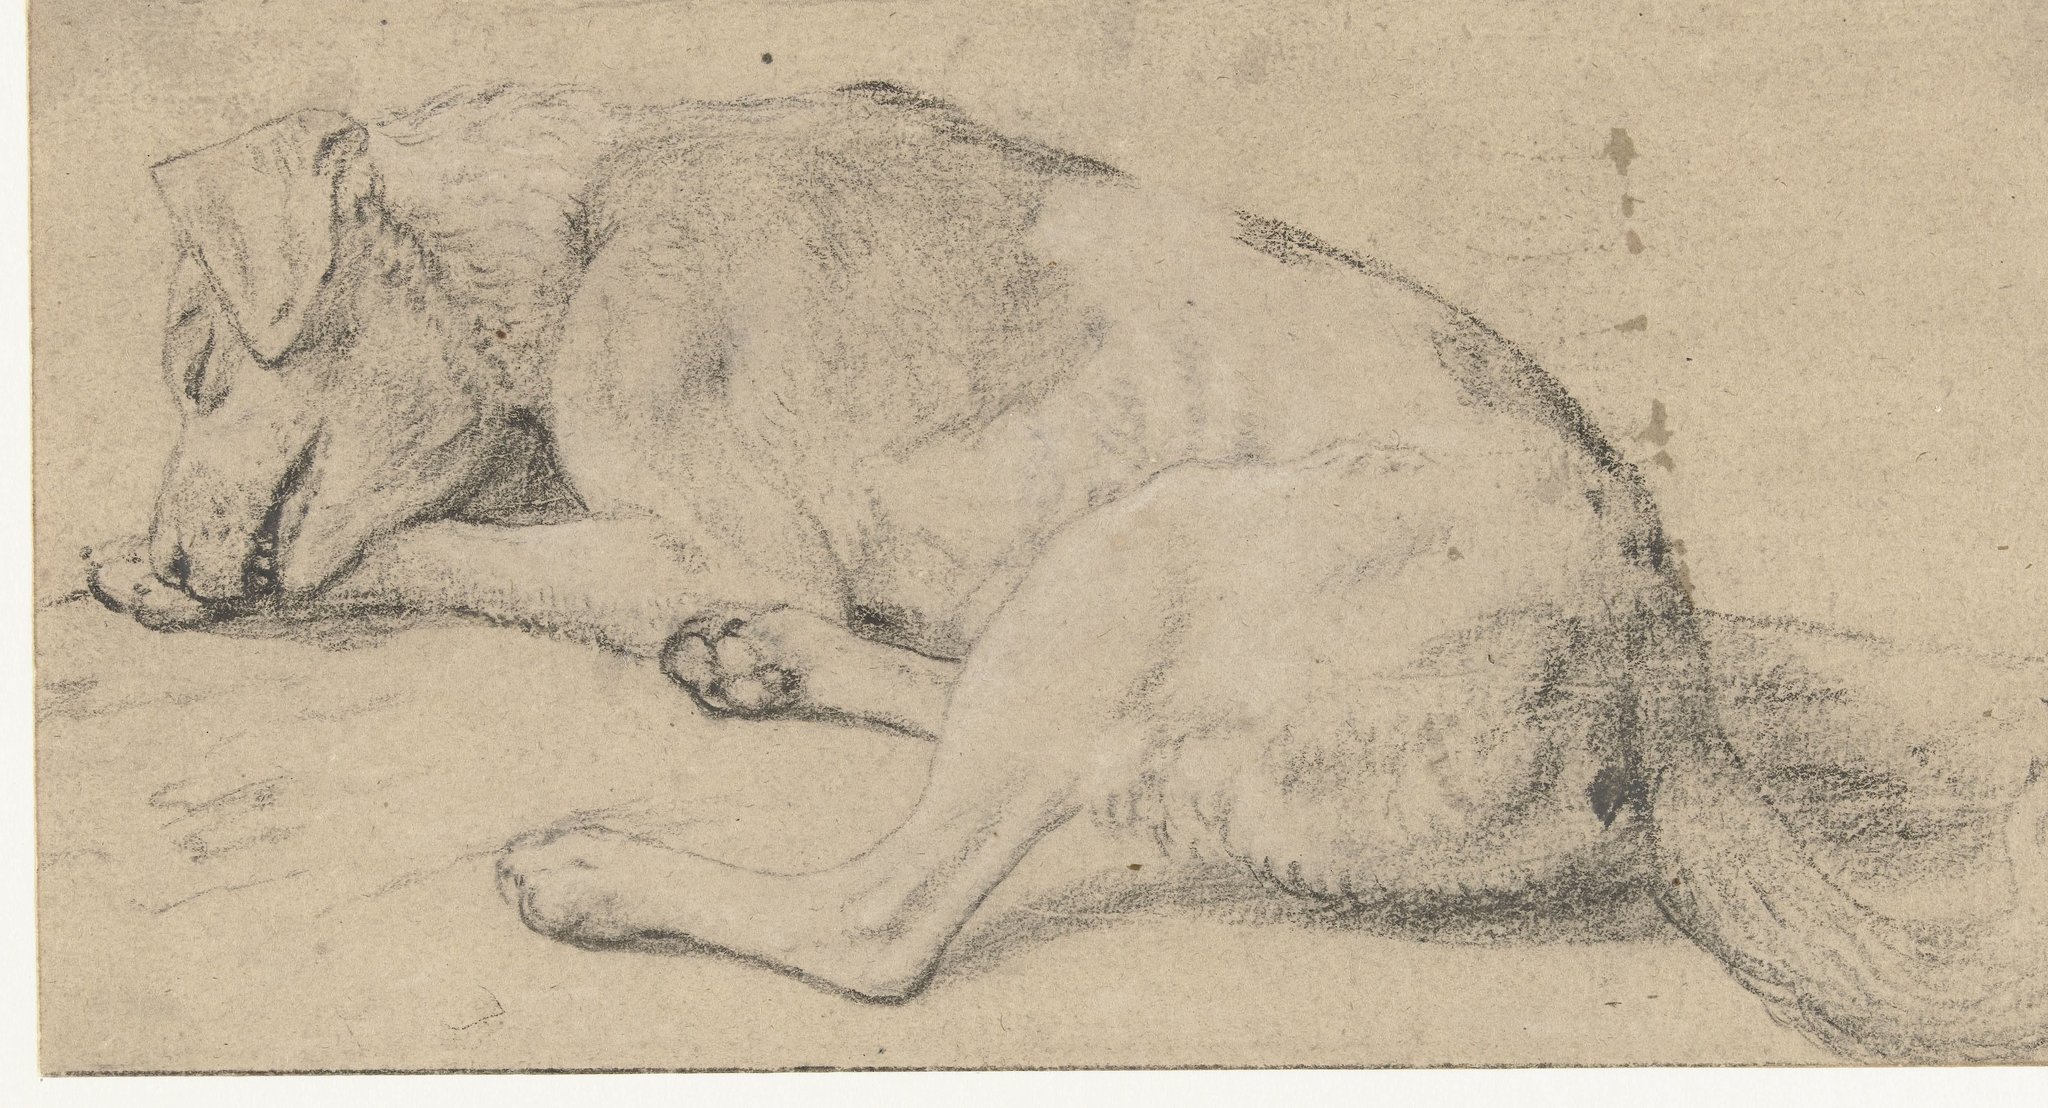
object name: drawing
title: Een slapende hond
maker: frans snijders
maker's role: draughtsman, painter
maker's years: 1579-1657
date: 1589-1657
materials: chalk, paper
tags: dog (+ sleeping animal(s))